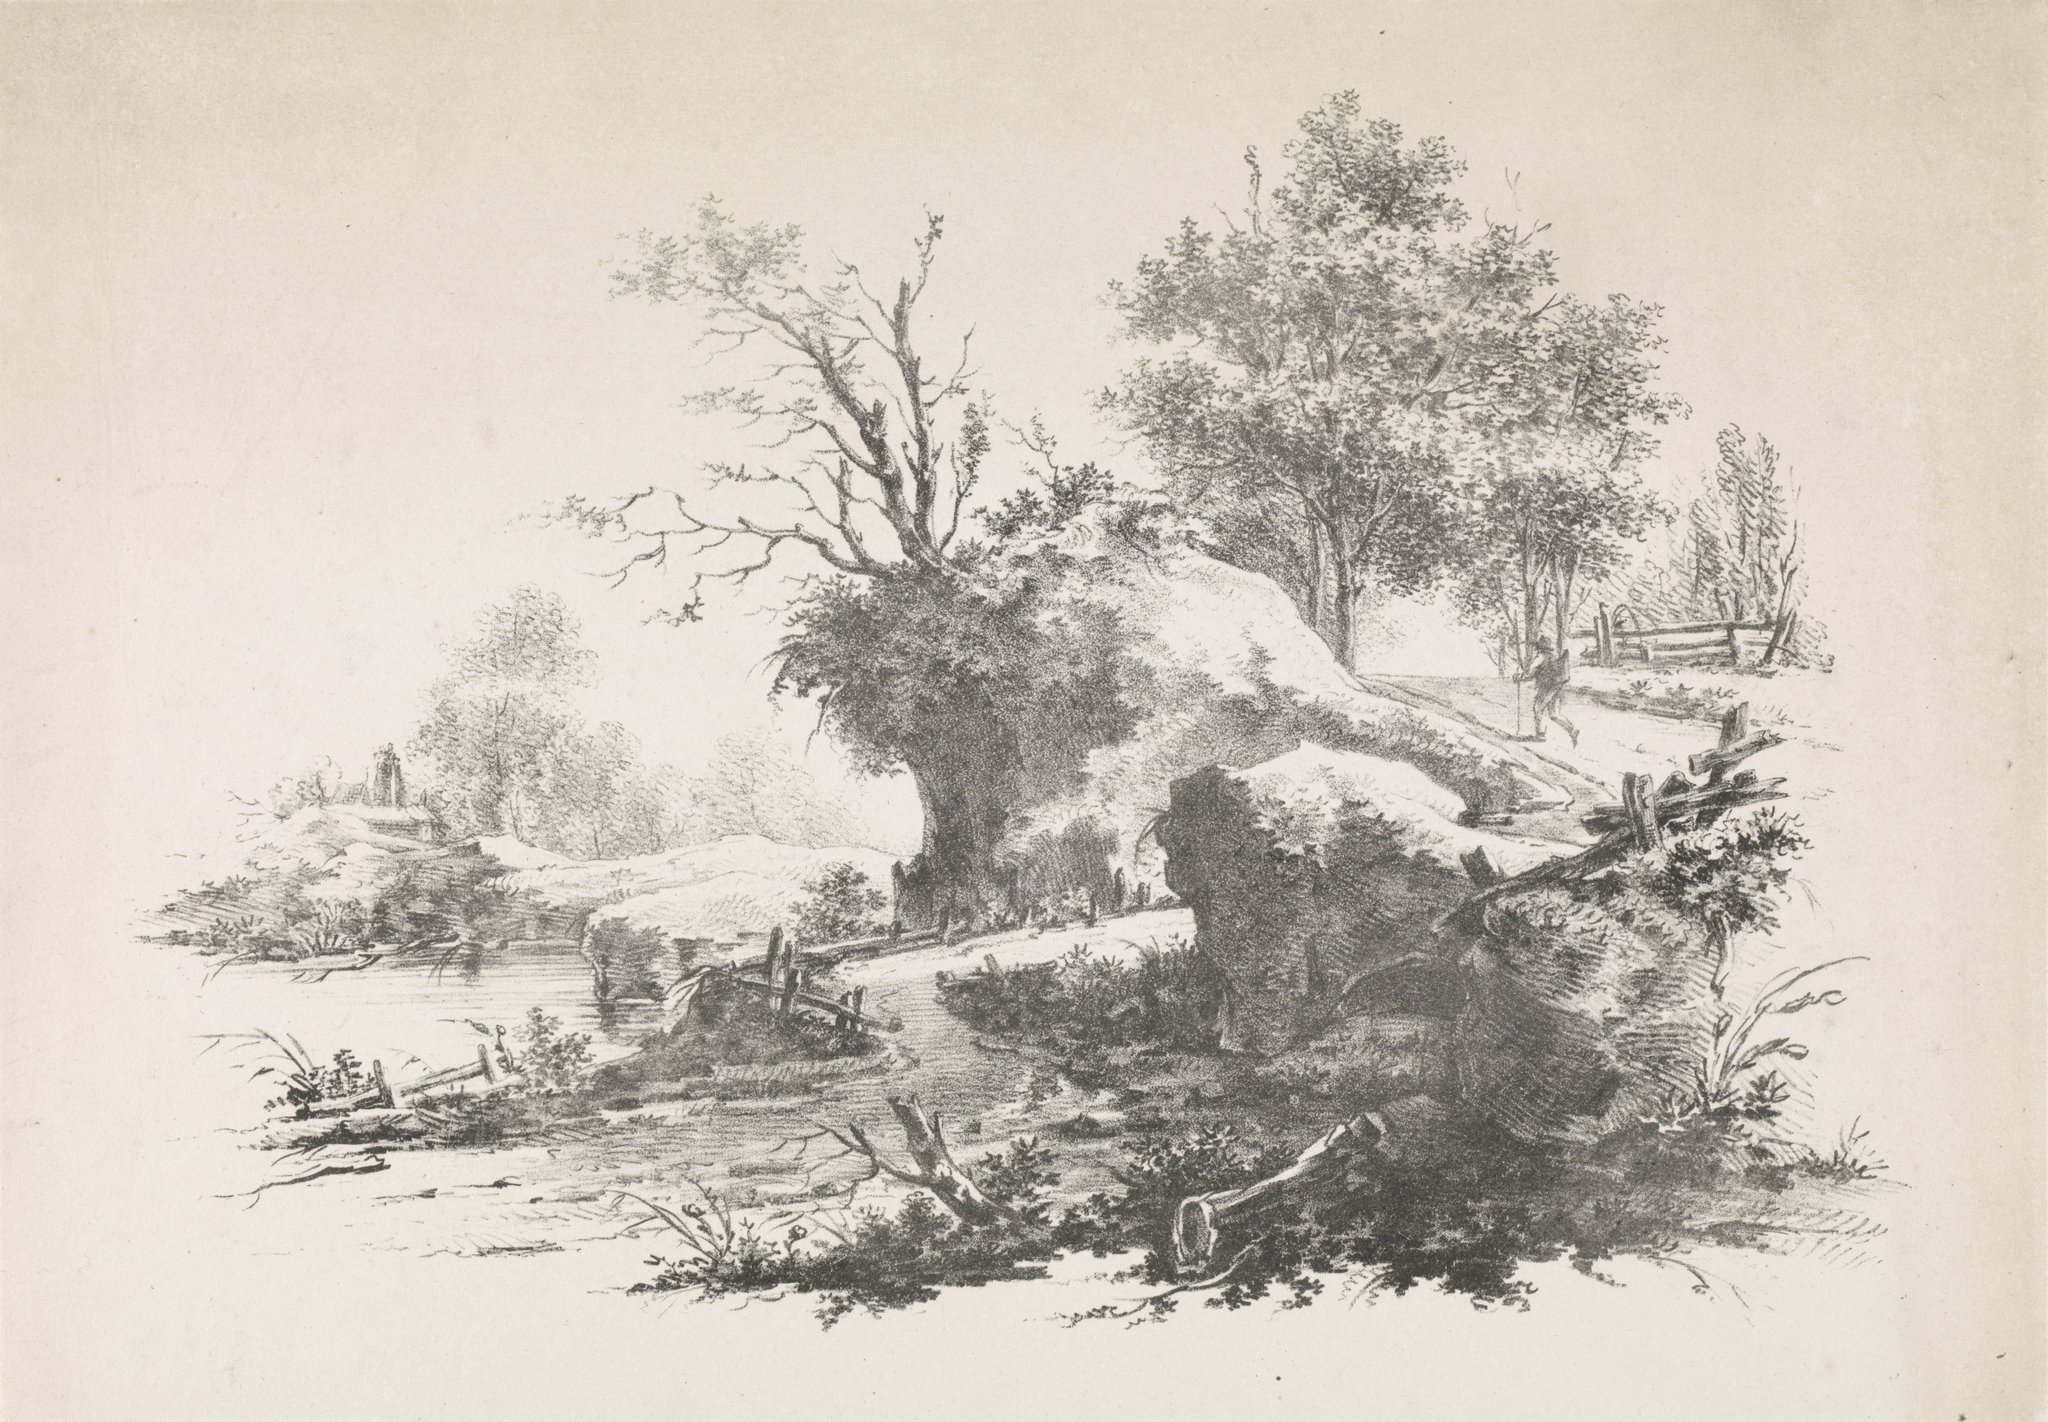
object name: print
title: Landschap met wandelaar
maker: joannes bemme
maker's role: print maker, printer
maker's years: 1775-1841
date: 1809-1841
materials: paper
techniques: lithograph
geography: netherlands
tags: low hill country, walking-stick, staff, public road (+ city(-scape) with figures, staffage)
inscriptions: collector's mark: Lugt 2228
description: Een zandpad loopt door een heuvelachtig landschap. Sommige stukken zijn afgezet met een hekwerk. Rechts loopt een figuur met een lange stok en een rugzak.